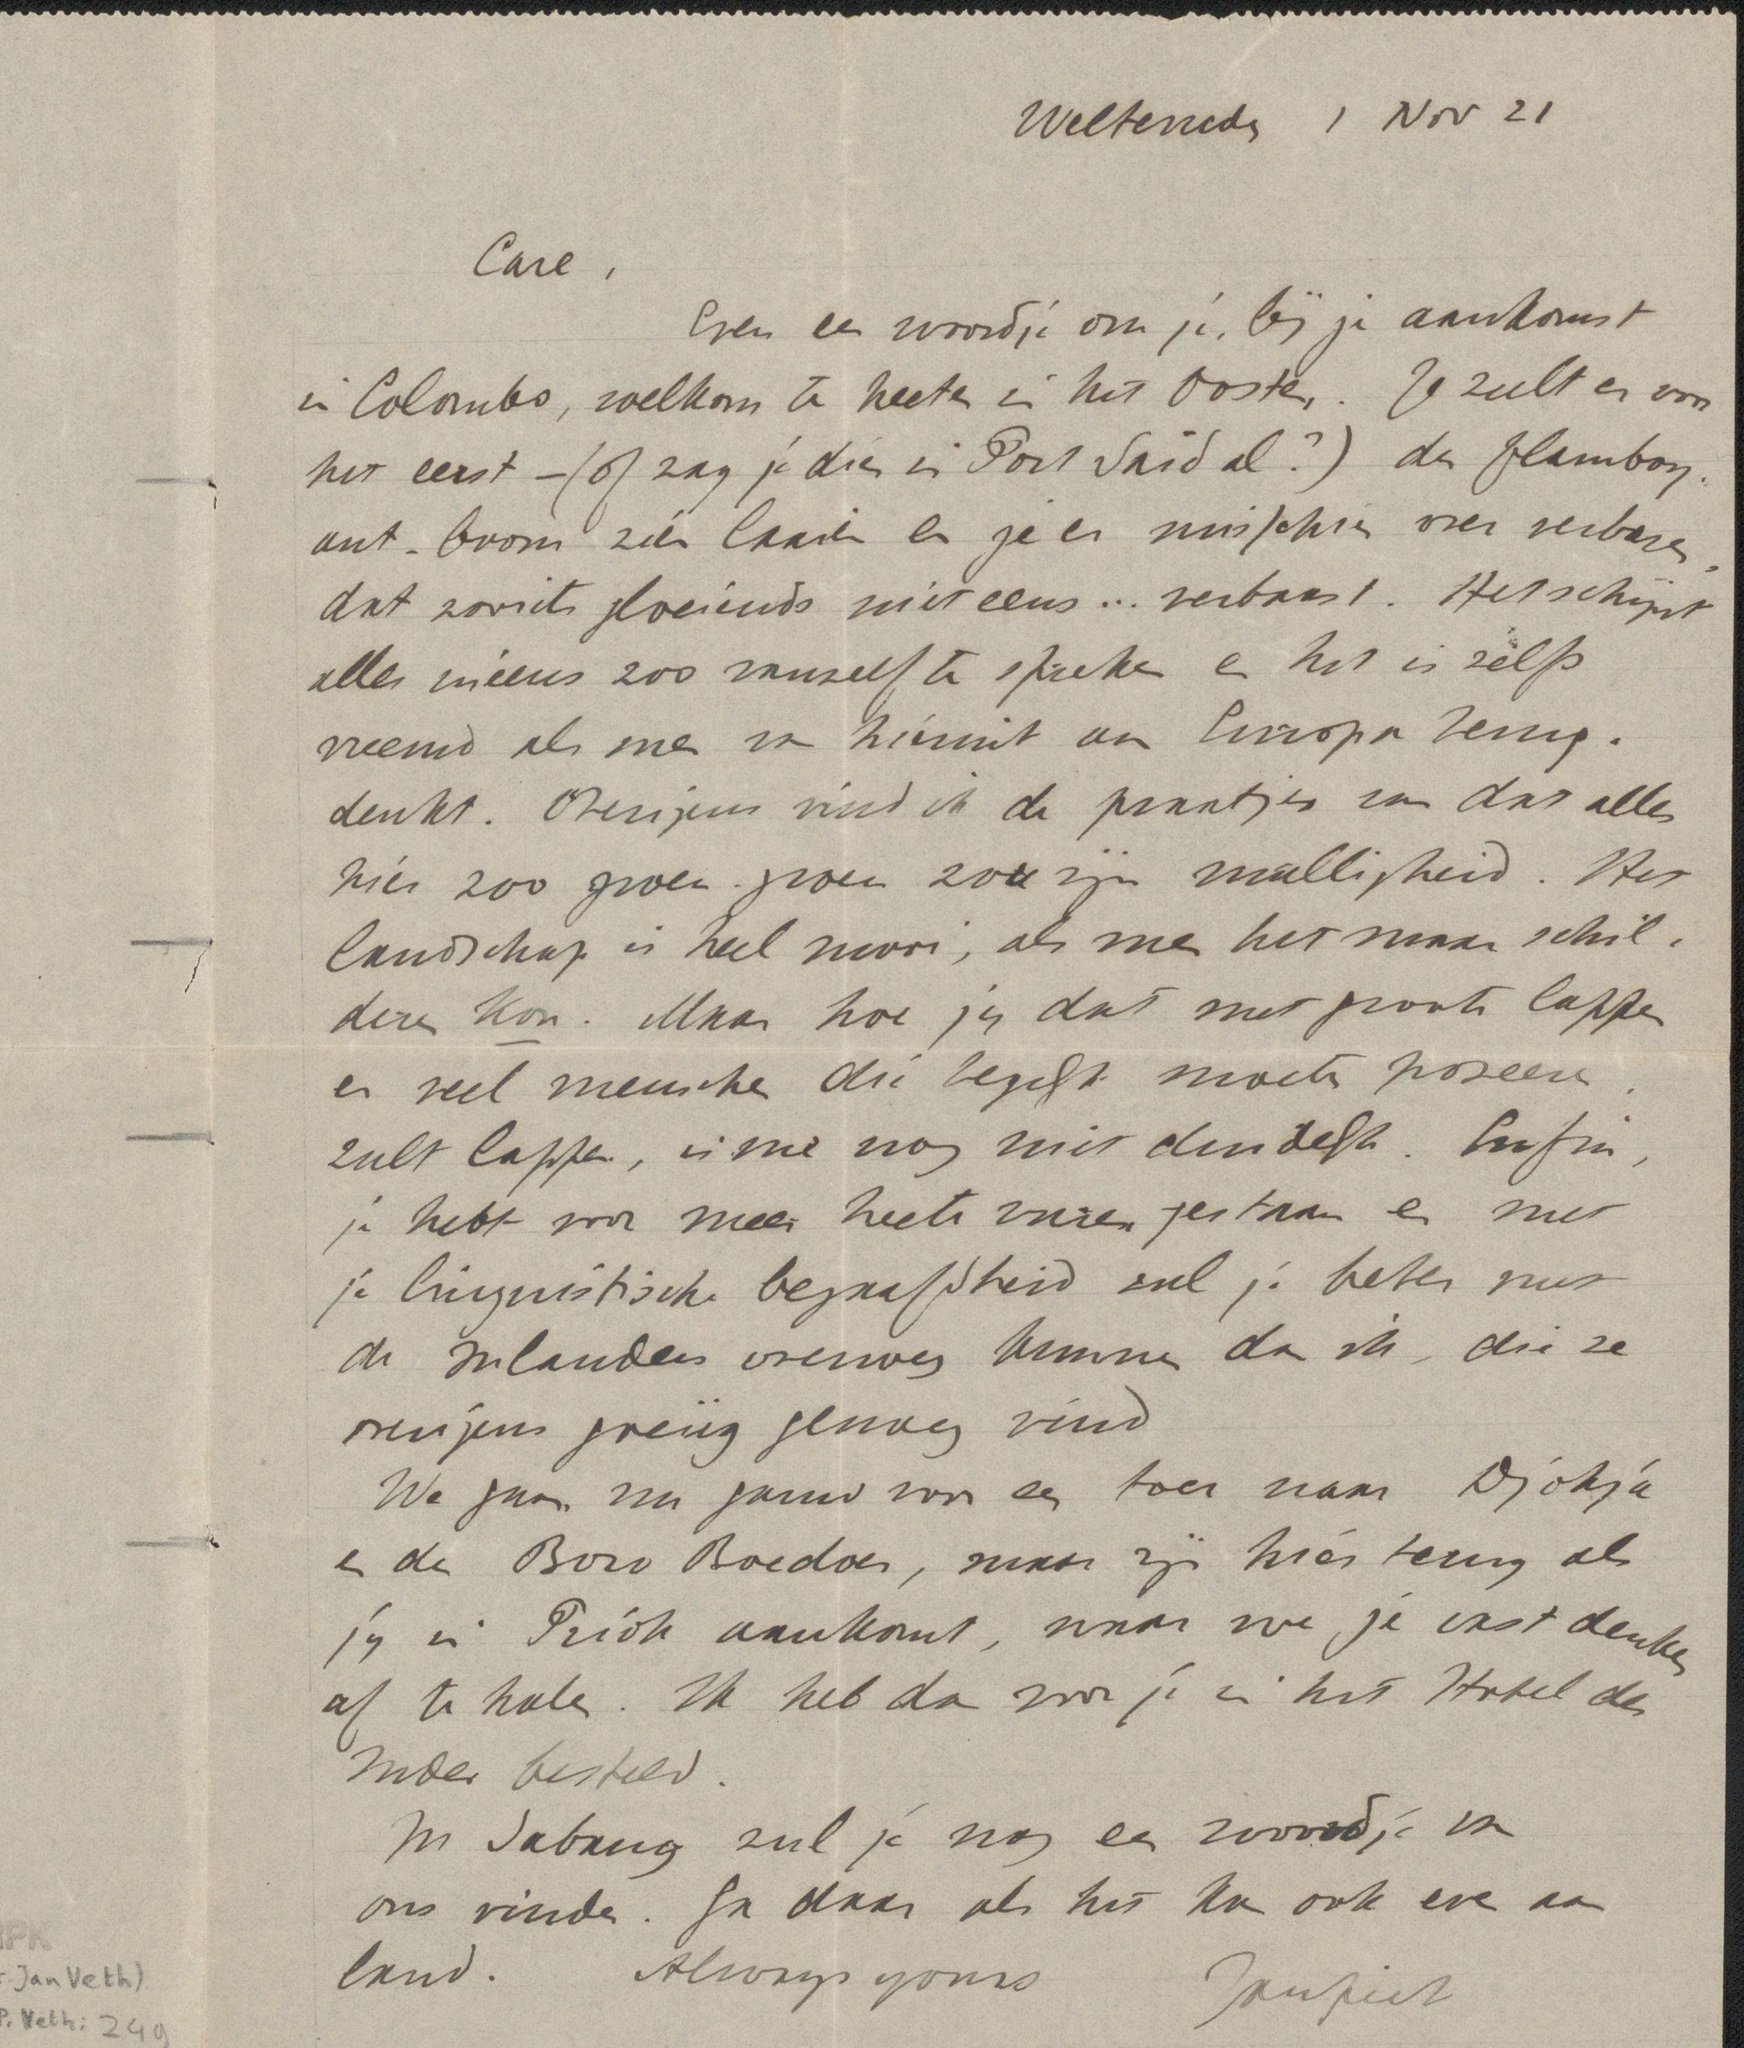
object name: letter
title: Brief aan Isaac Israels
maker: jan veth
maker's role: designer, draughtsman, painter, print maker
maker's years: 1864-1925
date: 1921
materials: ink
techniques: pen, writing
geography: weltevreden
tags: the hague, isaac israels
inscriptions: collector's mark: ‘RPK’